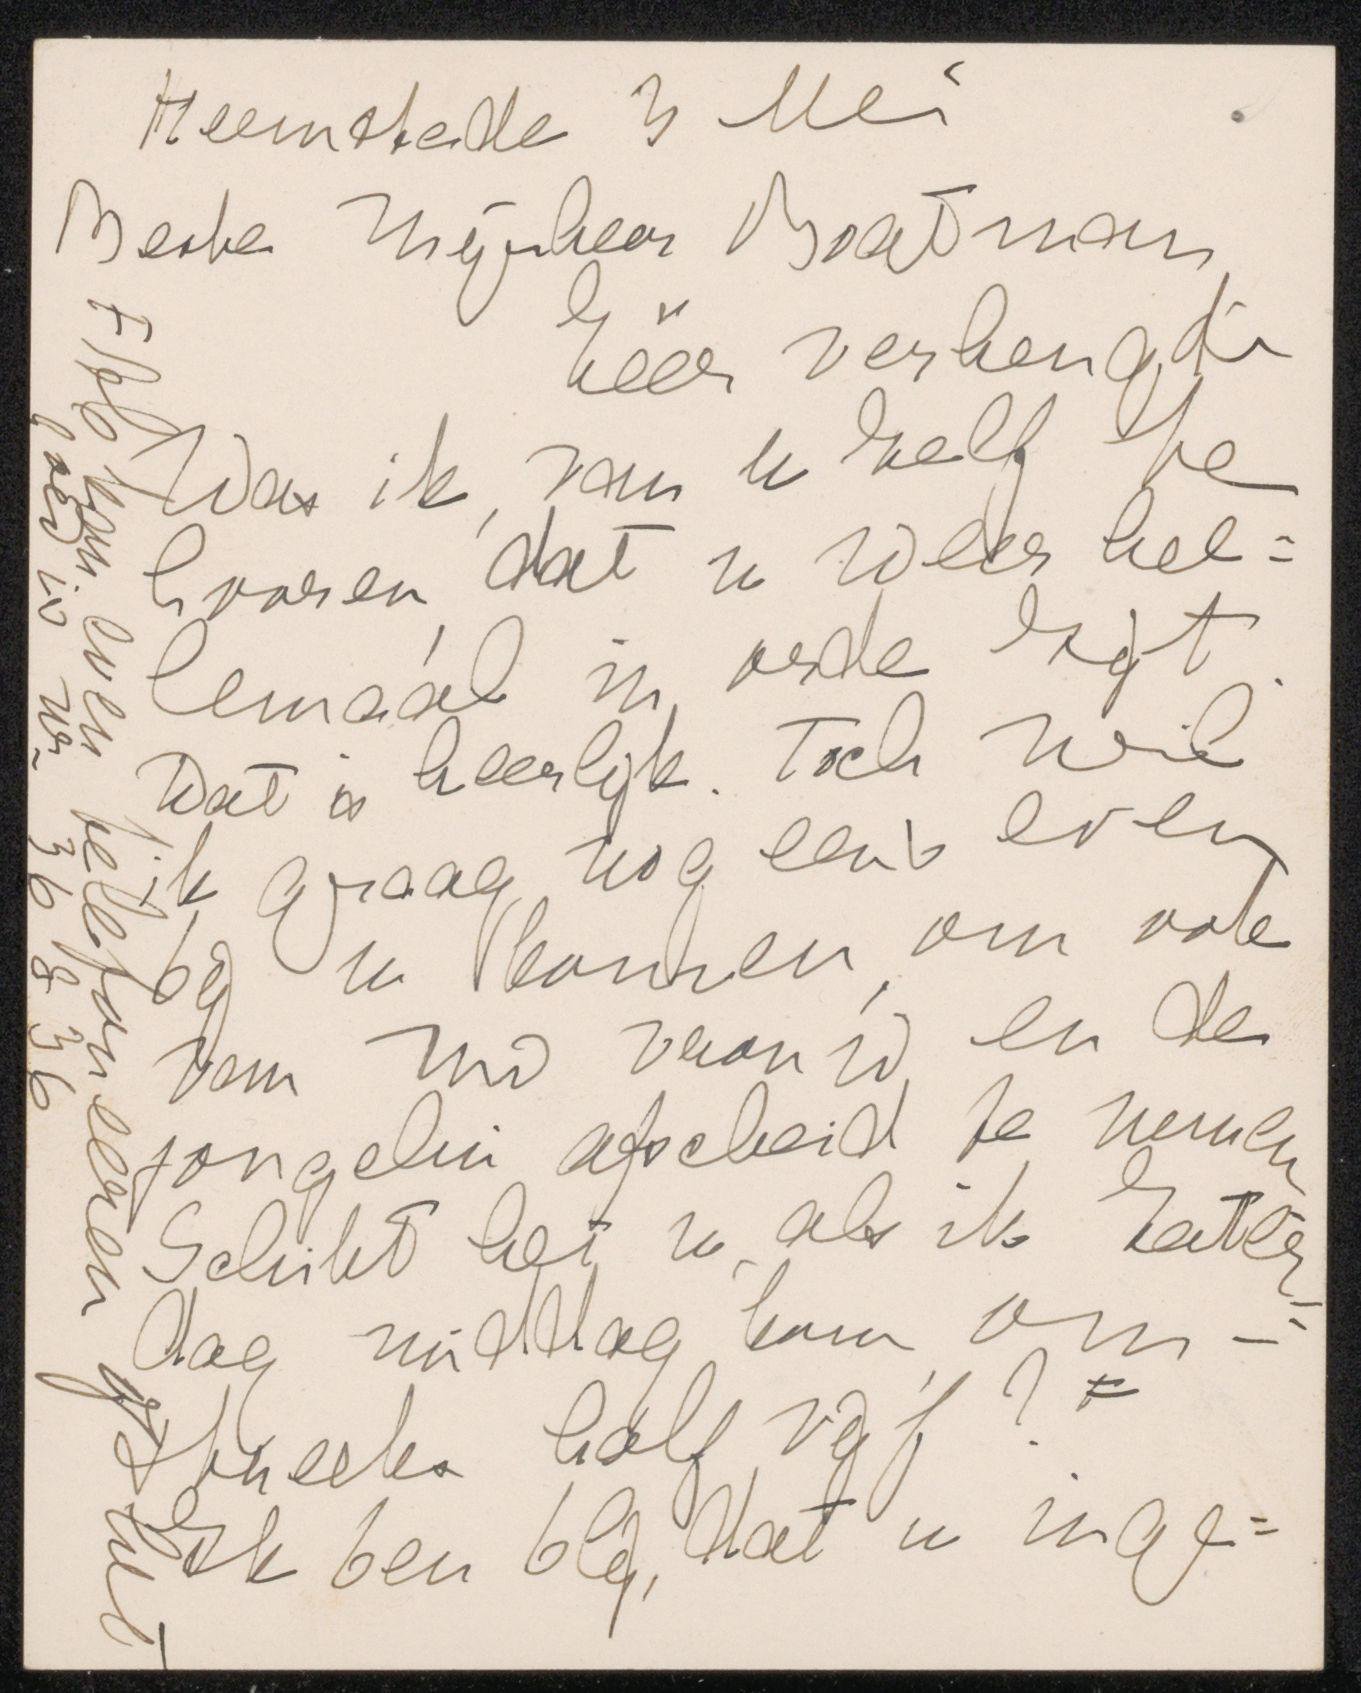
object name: letter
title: Brief aan Willem Bogtman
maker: henriëtte roland holst-van der schalk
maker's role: dichter, schrijver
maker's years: 1869-1952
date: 1939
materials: ink, paper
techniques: pen, writing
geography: heemstede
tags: ab bogtman, haarlem, willem bogtman, richard nicolaüs roland holst, applied arts, arts and crafts; industrial design, diseases